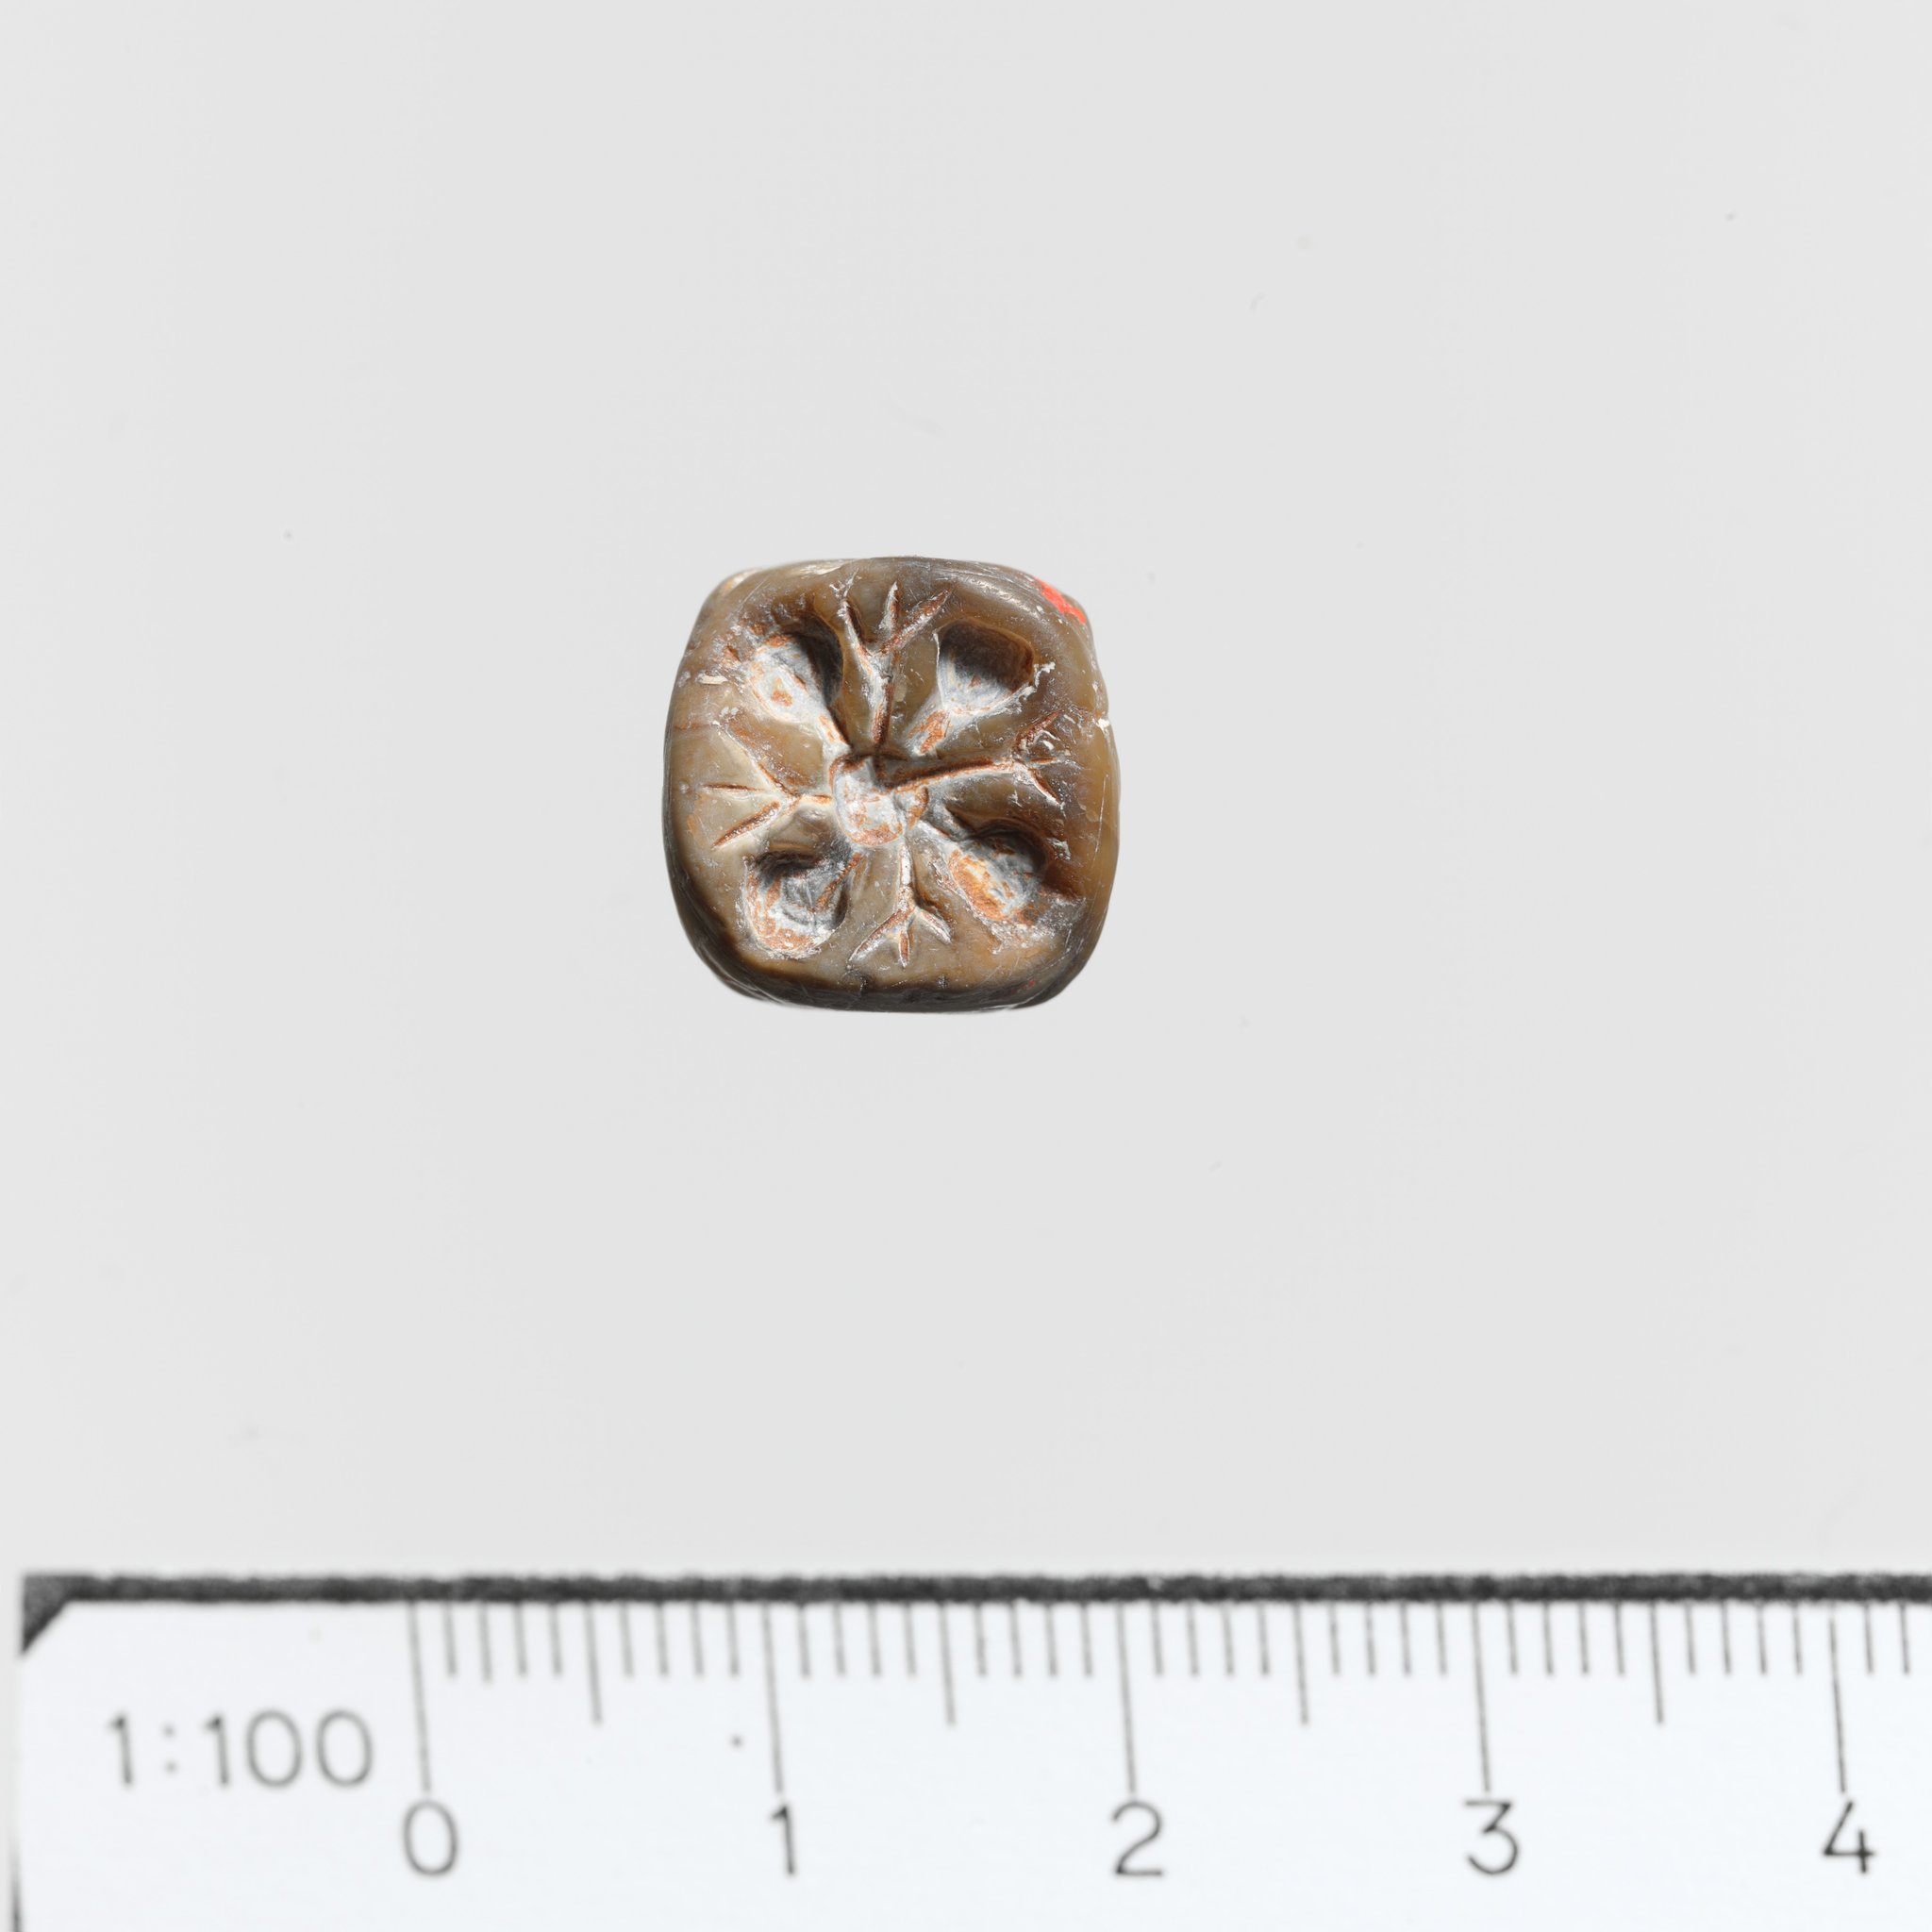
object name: seal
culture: minoan, crete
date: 2000-1800 BCE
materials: stone